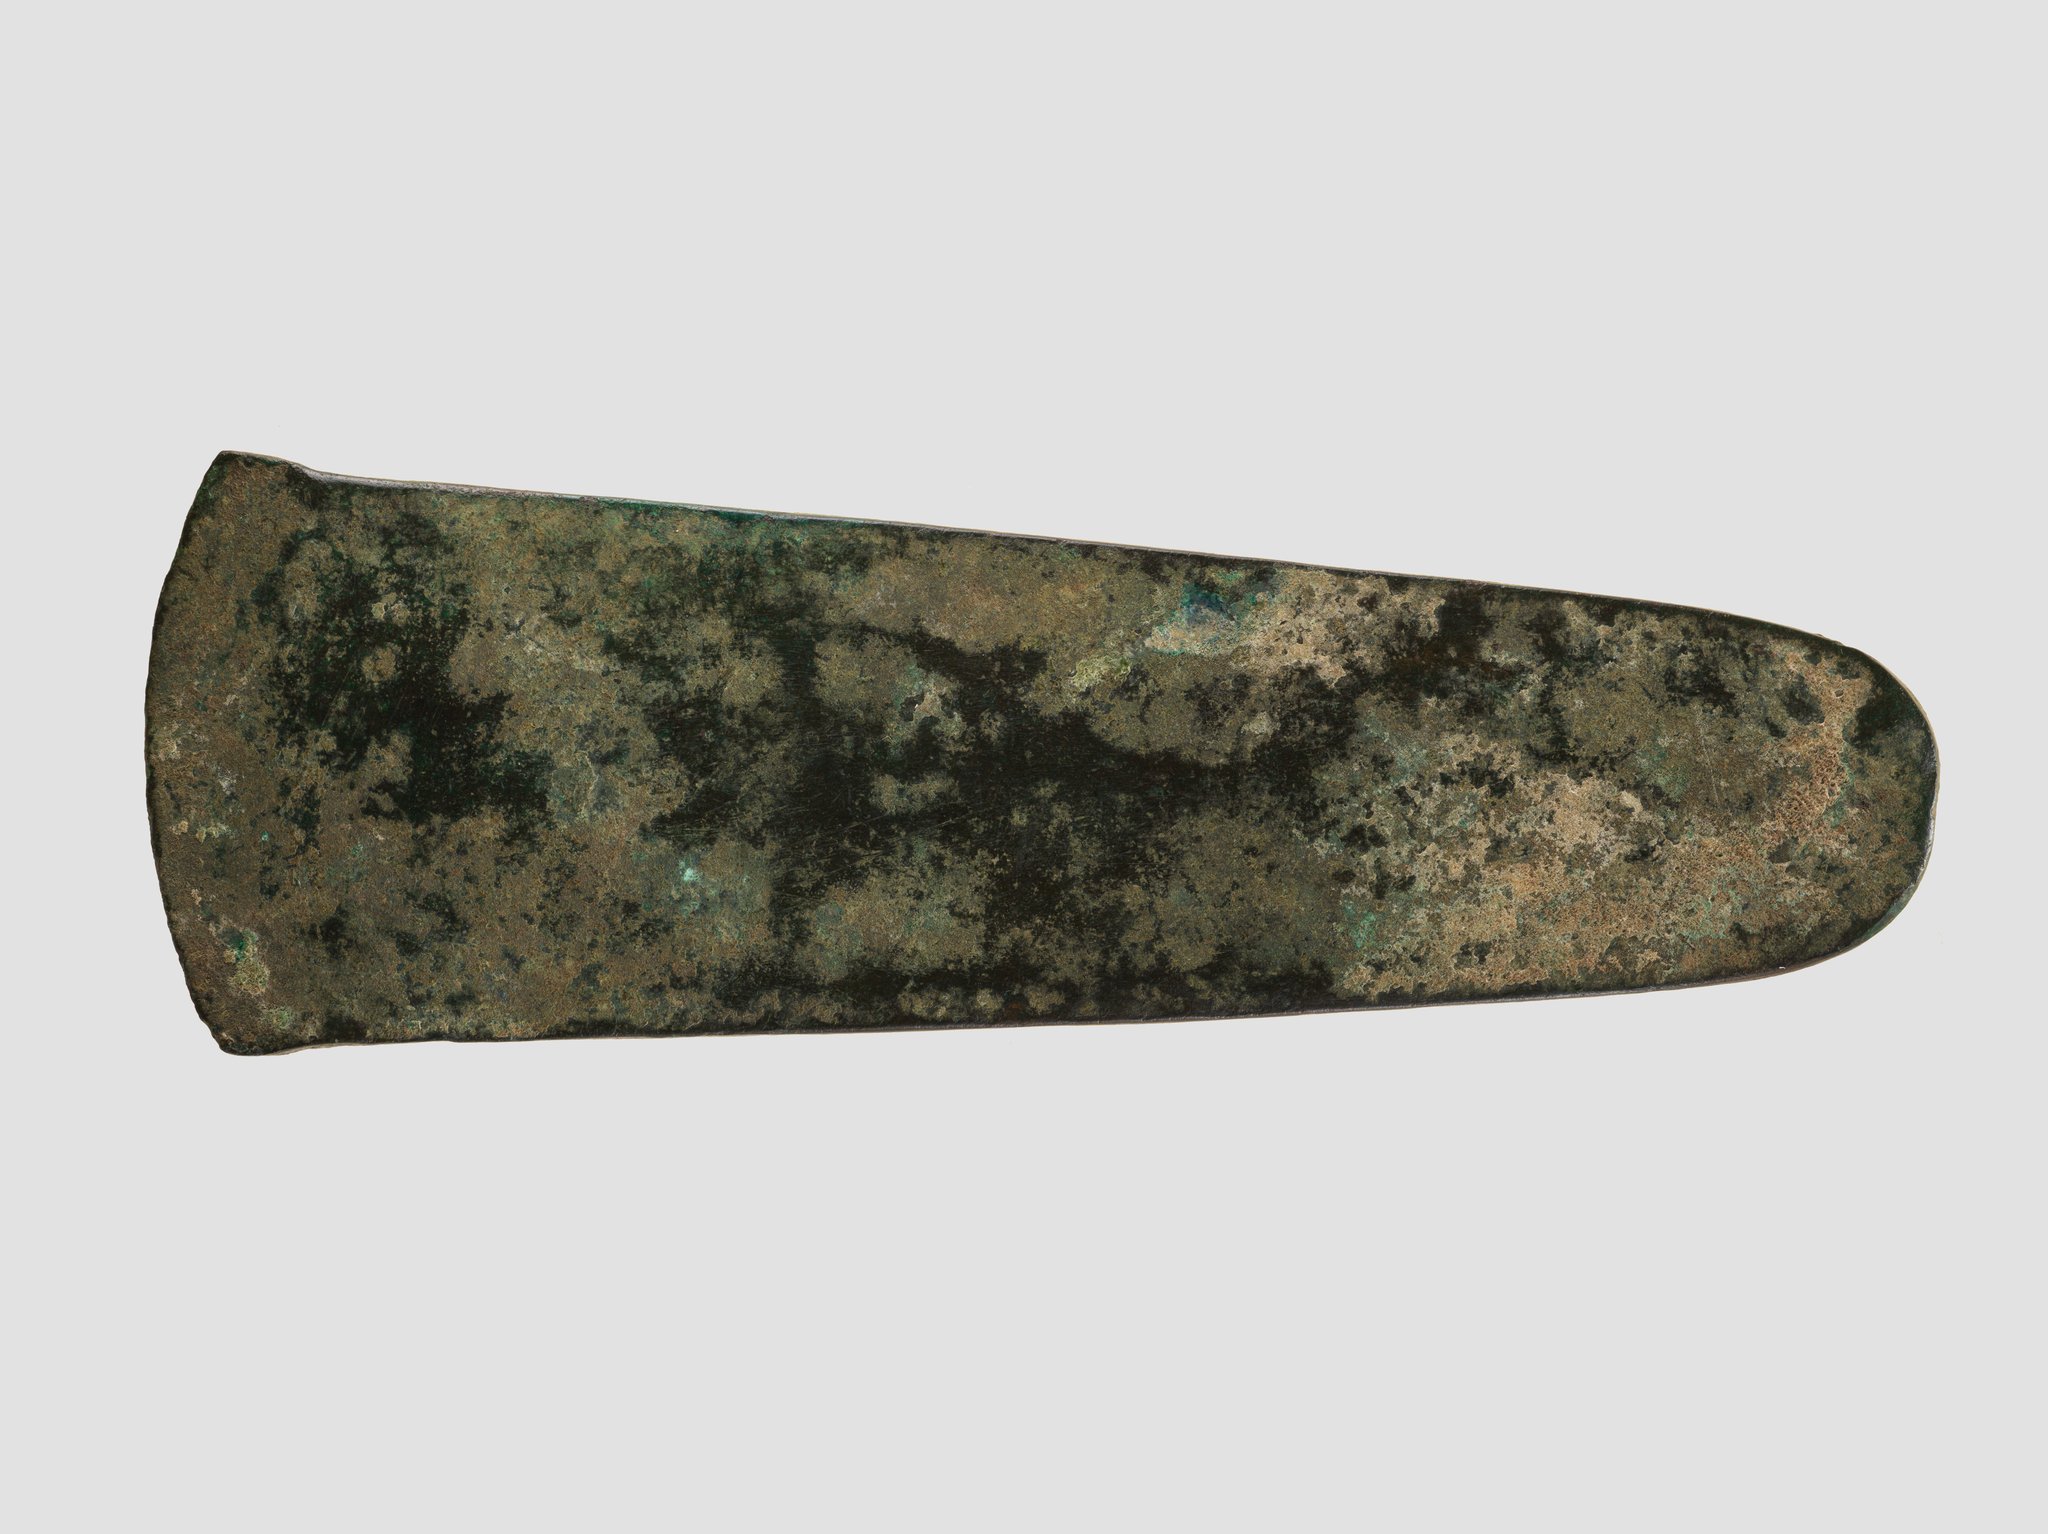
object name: axe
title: Axe head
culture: hattian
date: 2300-2000 BCE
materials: bronze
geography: central anatolia